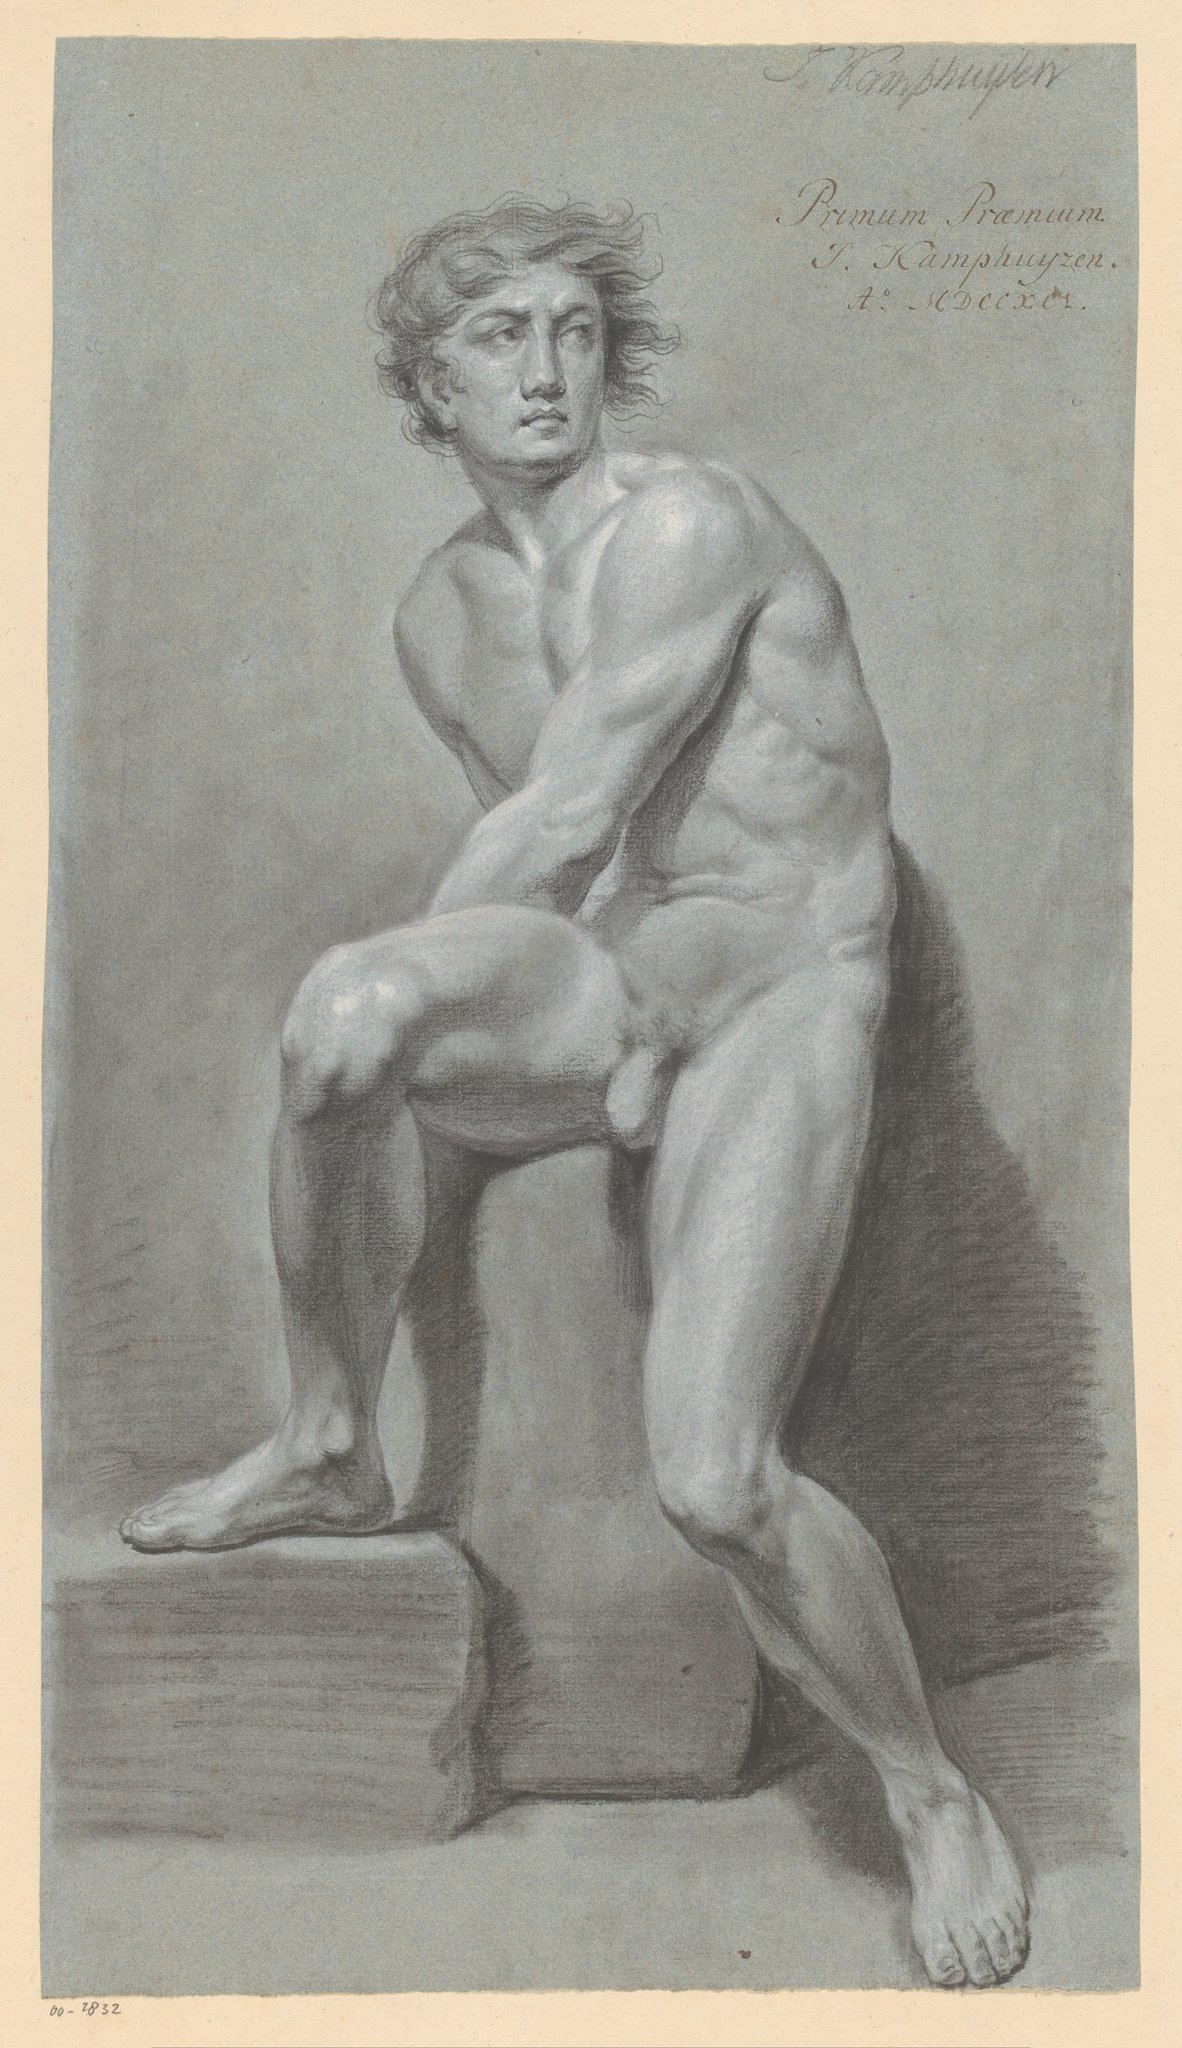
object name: drawing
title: Zittend mannelijk naakt, van voren gezien (1e prijs 1791)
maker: jan kamphuijsen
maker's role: draughtsman, painter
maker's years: 1760-1841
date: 1791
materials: chalk, paper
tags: sitting figure (+ nude human being)